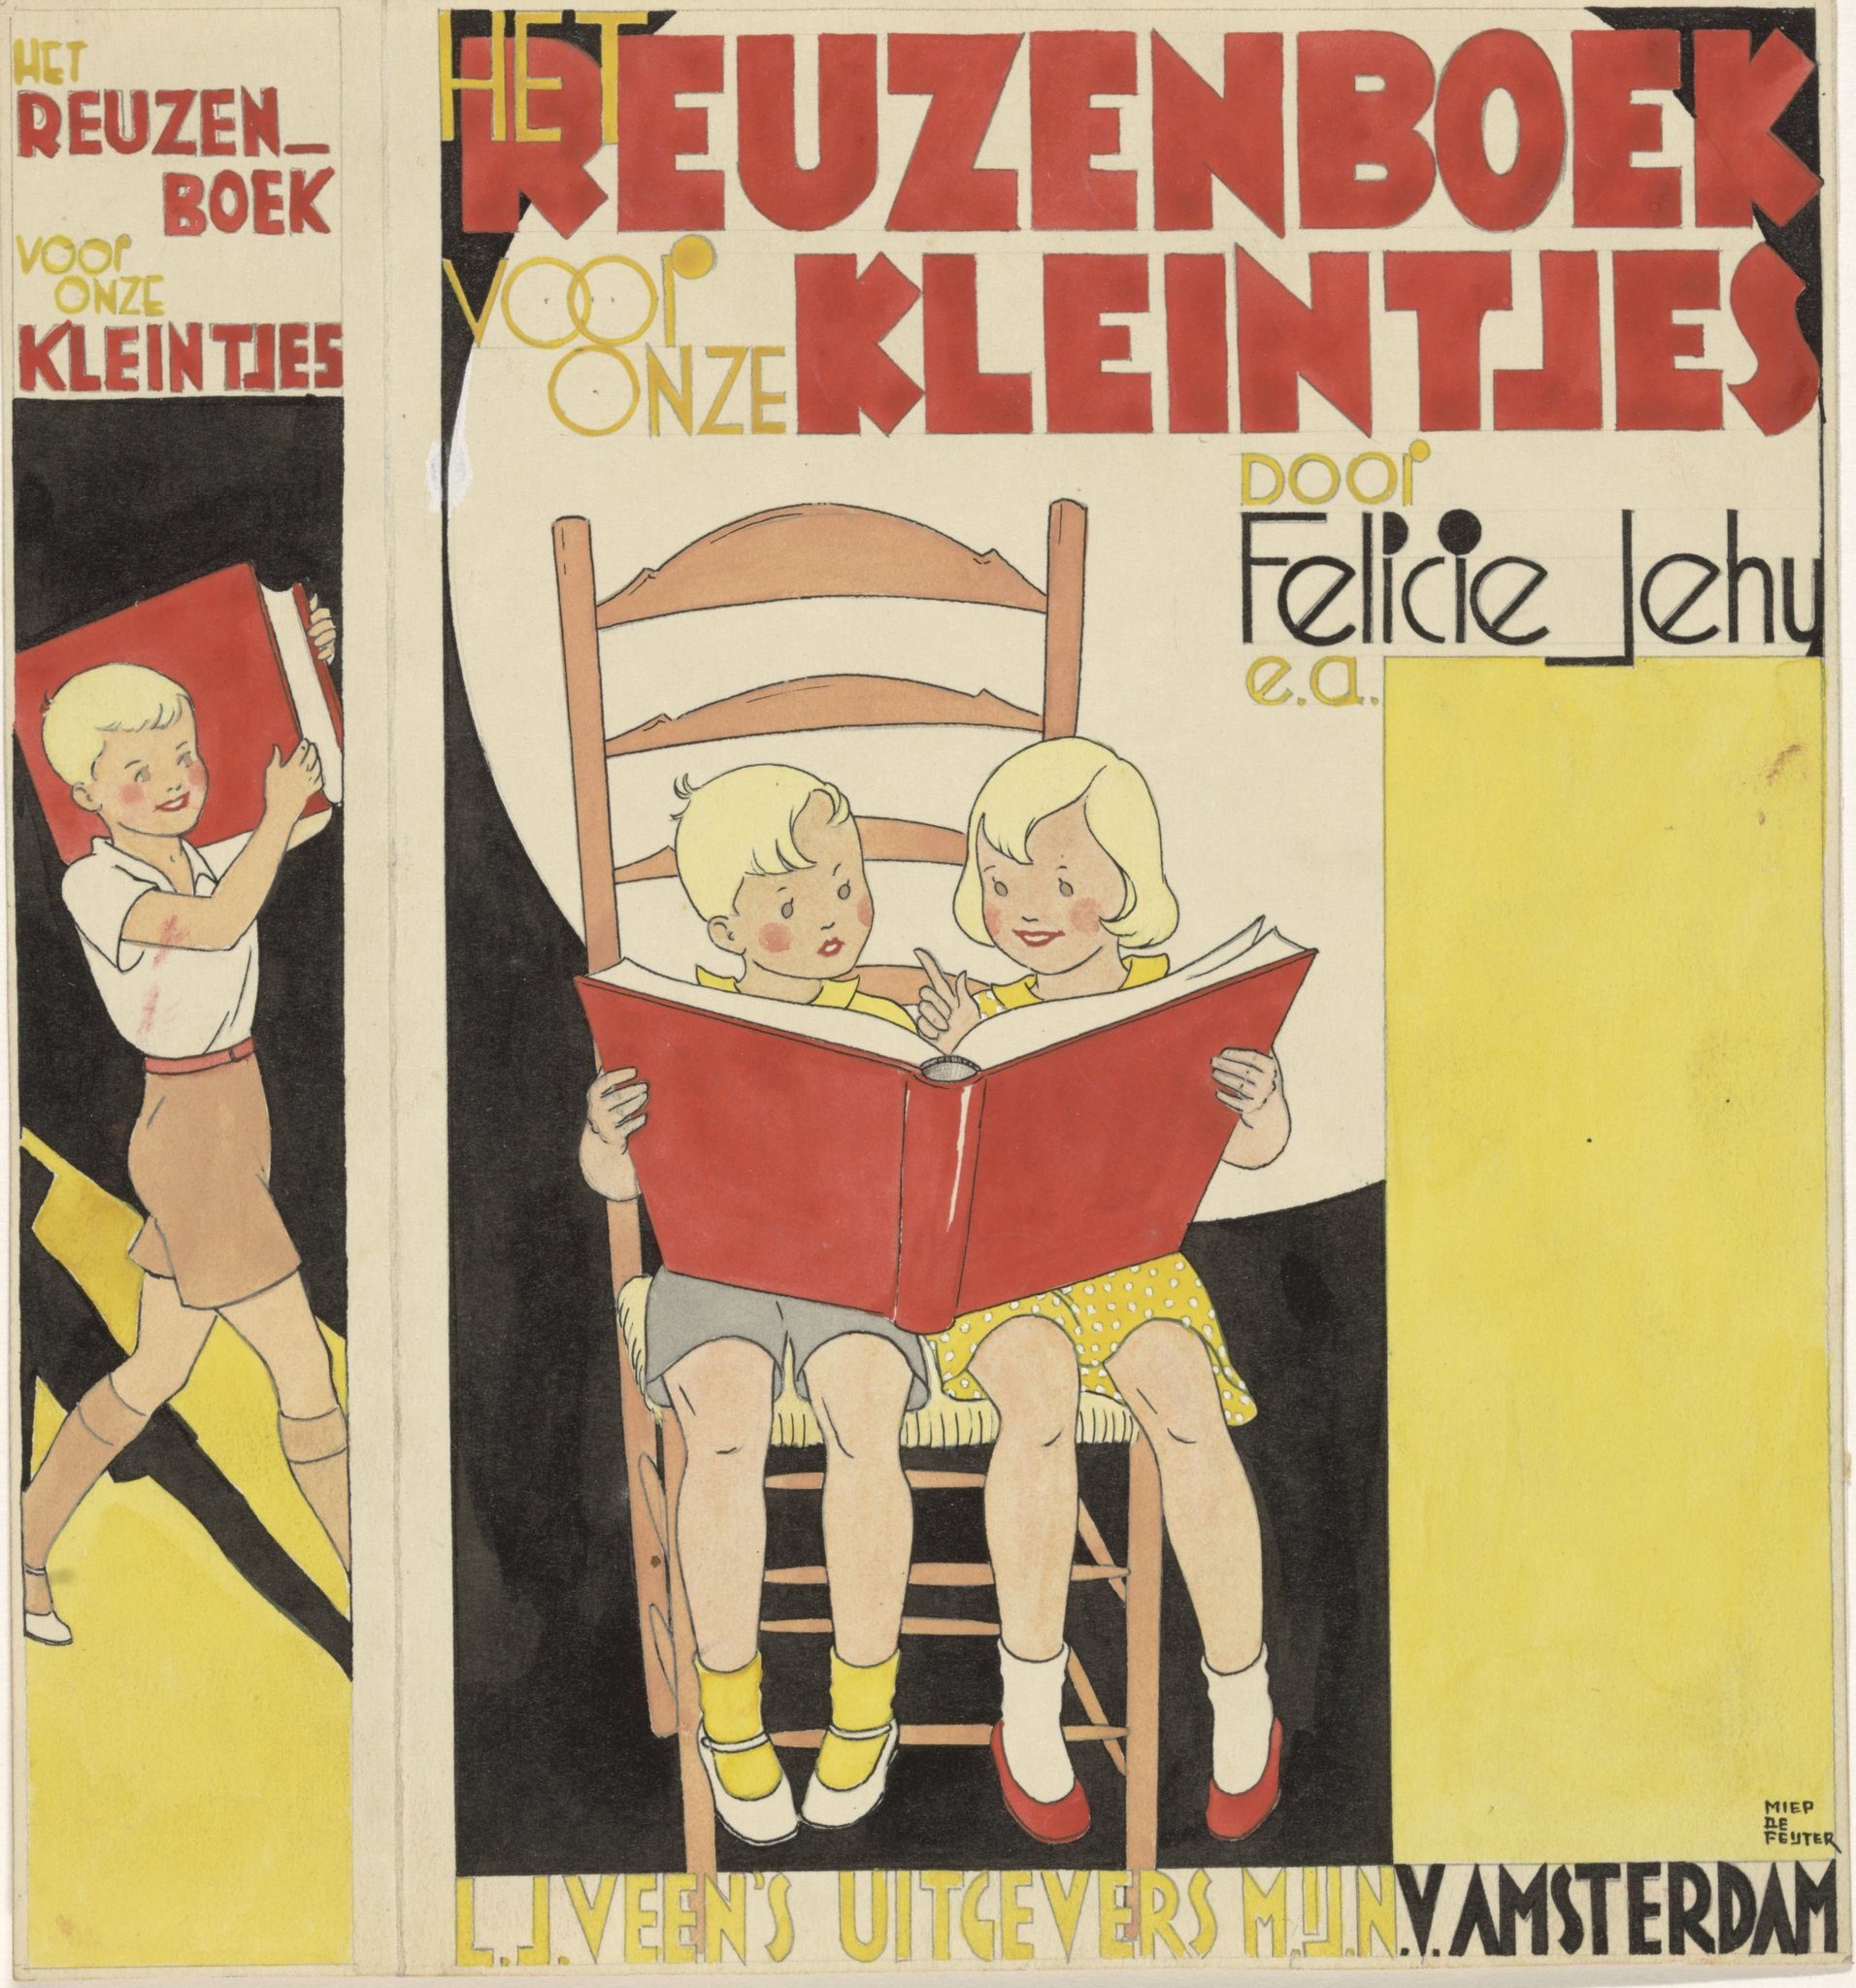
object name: drawing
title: Bandontwerp voor: Felicie Jehu e.a., Het reuzenboek voor onze kleintjes, 1937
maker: miep de feijter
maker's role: draughtsman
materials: paint, ink, paper, pencil, watercolor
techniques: brush, pen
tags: reading, child, table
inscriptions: :, collector's mark: Lugt 2228a, signature: ‘MIEP/ DE/ FEIJTER’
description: Een jongen en meisje zitten samen op een stoel in een boek te lezen. Op de rug een lopende jongen die het boek op de schouder draagt.